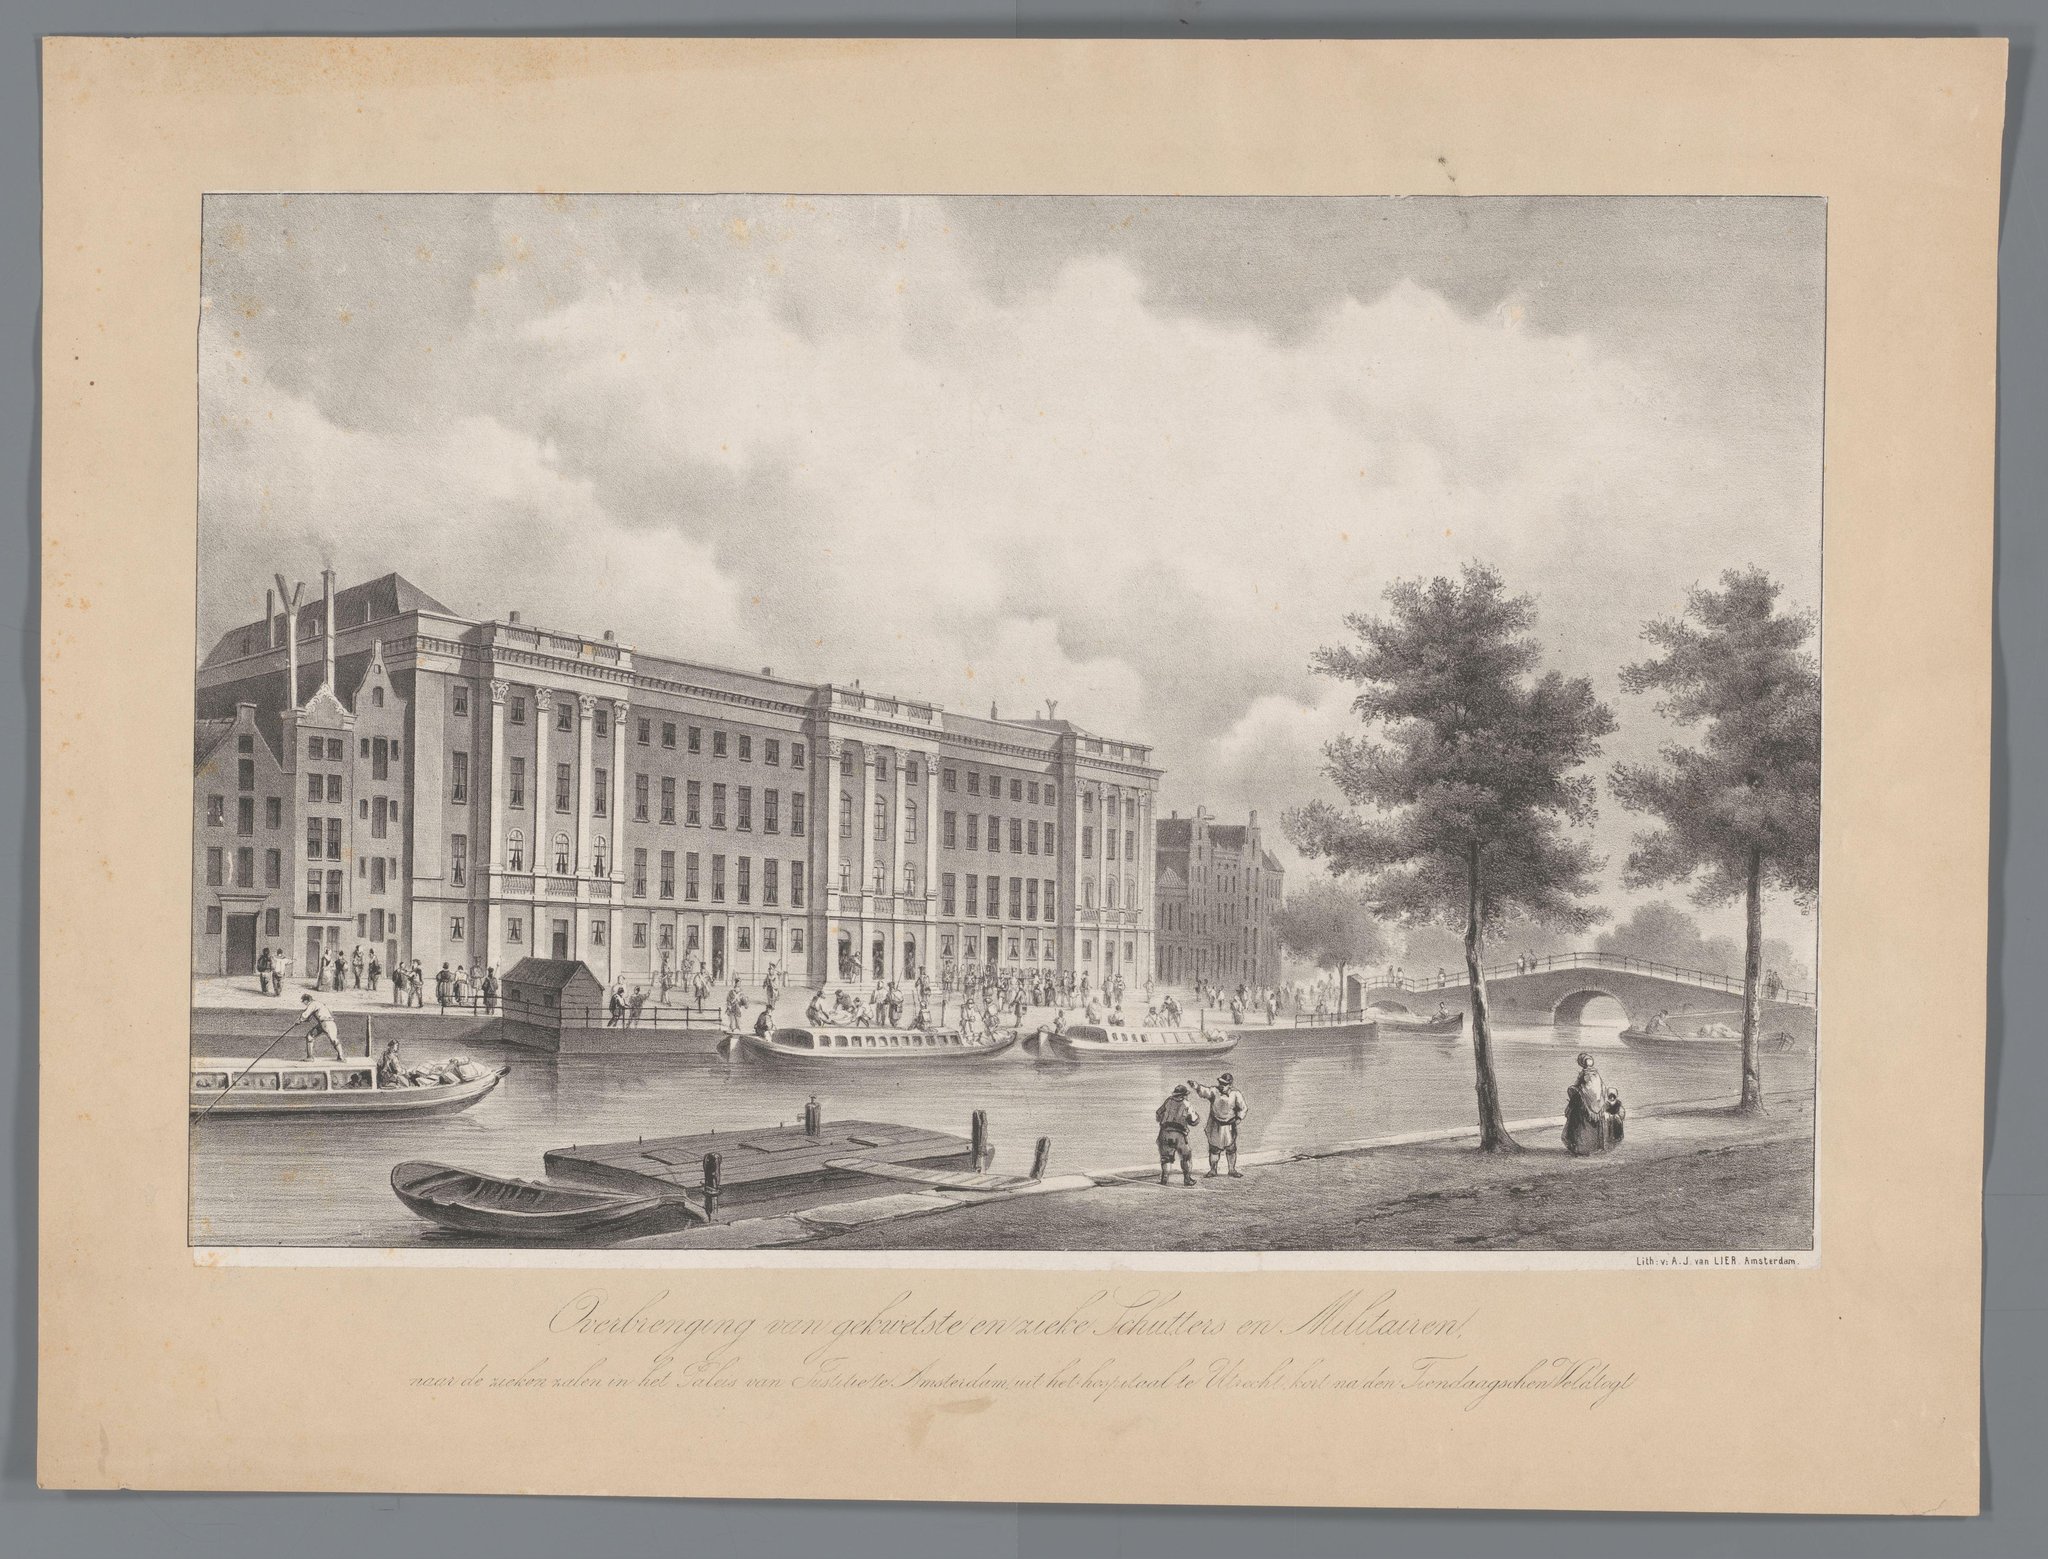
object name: print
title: Overbrenging van gekwetste en zieke Schutters en Militairen, naar de zieken zalen in het Paleis van Justitie te Amsterdam (...) na den Tiendaagschen Veldtogt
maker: a.j. van lier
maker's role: steendrukker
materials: paper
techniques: lithograph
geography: amsterdam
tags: hospital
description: De steendrukkerij van A.J. van Lier wordt in het Algemeen Handelsblad van 23 februari 1865 geprezen voor het uitgeven van deze plaat ten bate van een goed doel. Op grond van deze nieuwe informatie is de vervaardiging van deze prent die traditioneel in 1831 werd gedateerd veranderd naar 1865.